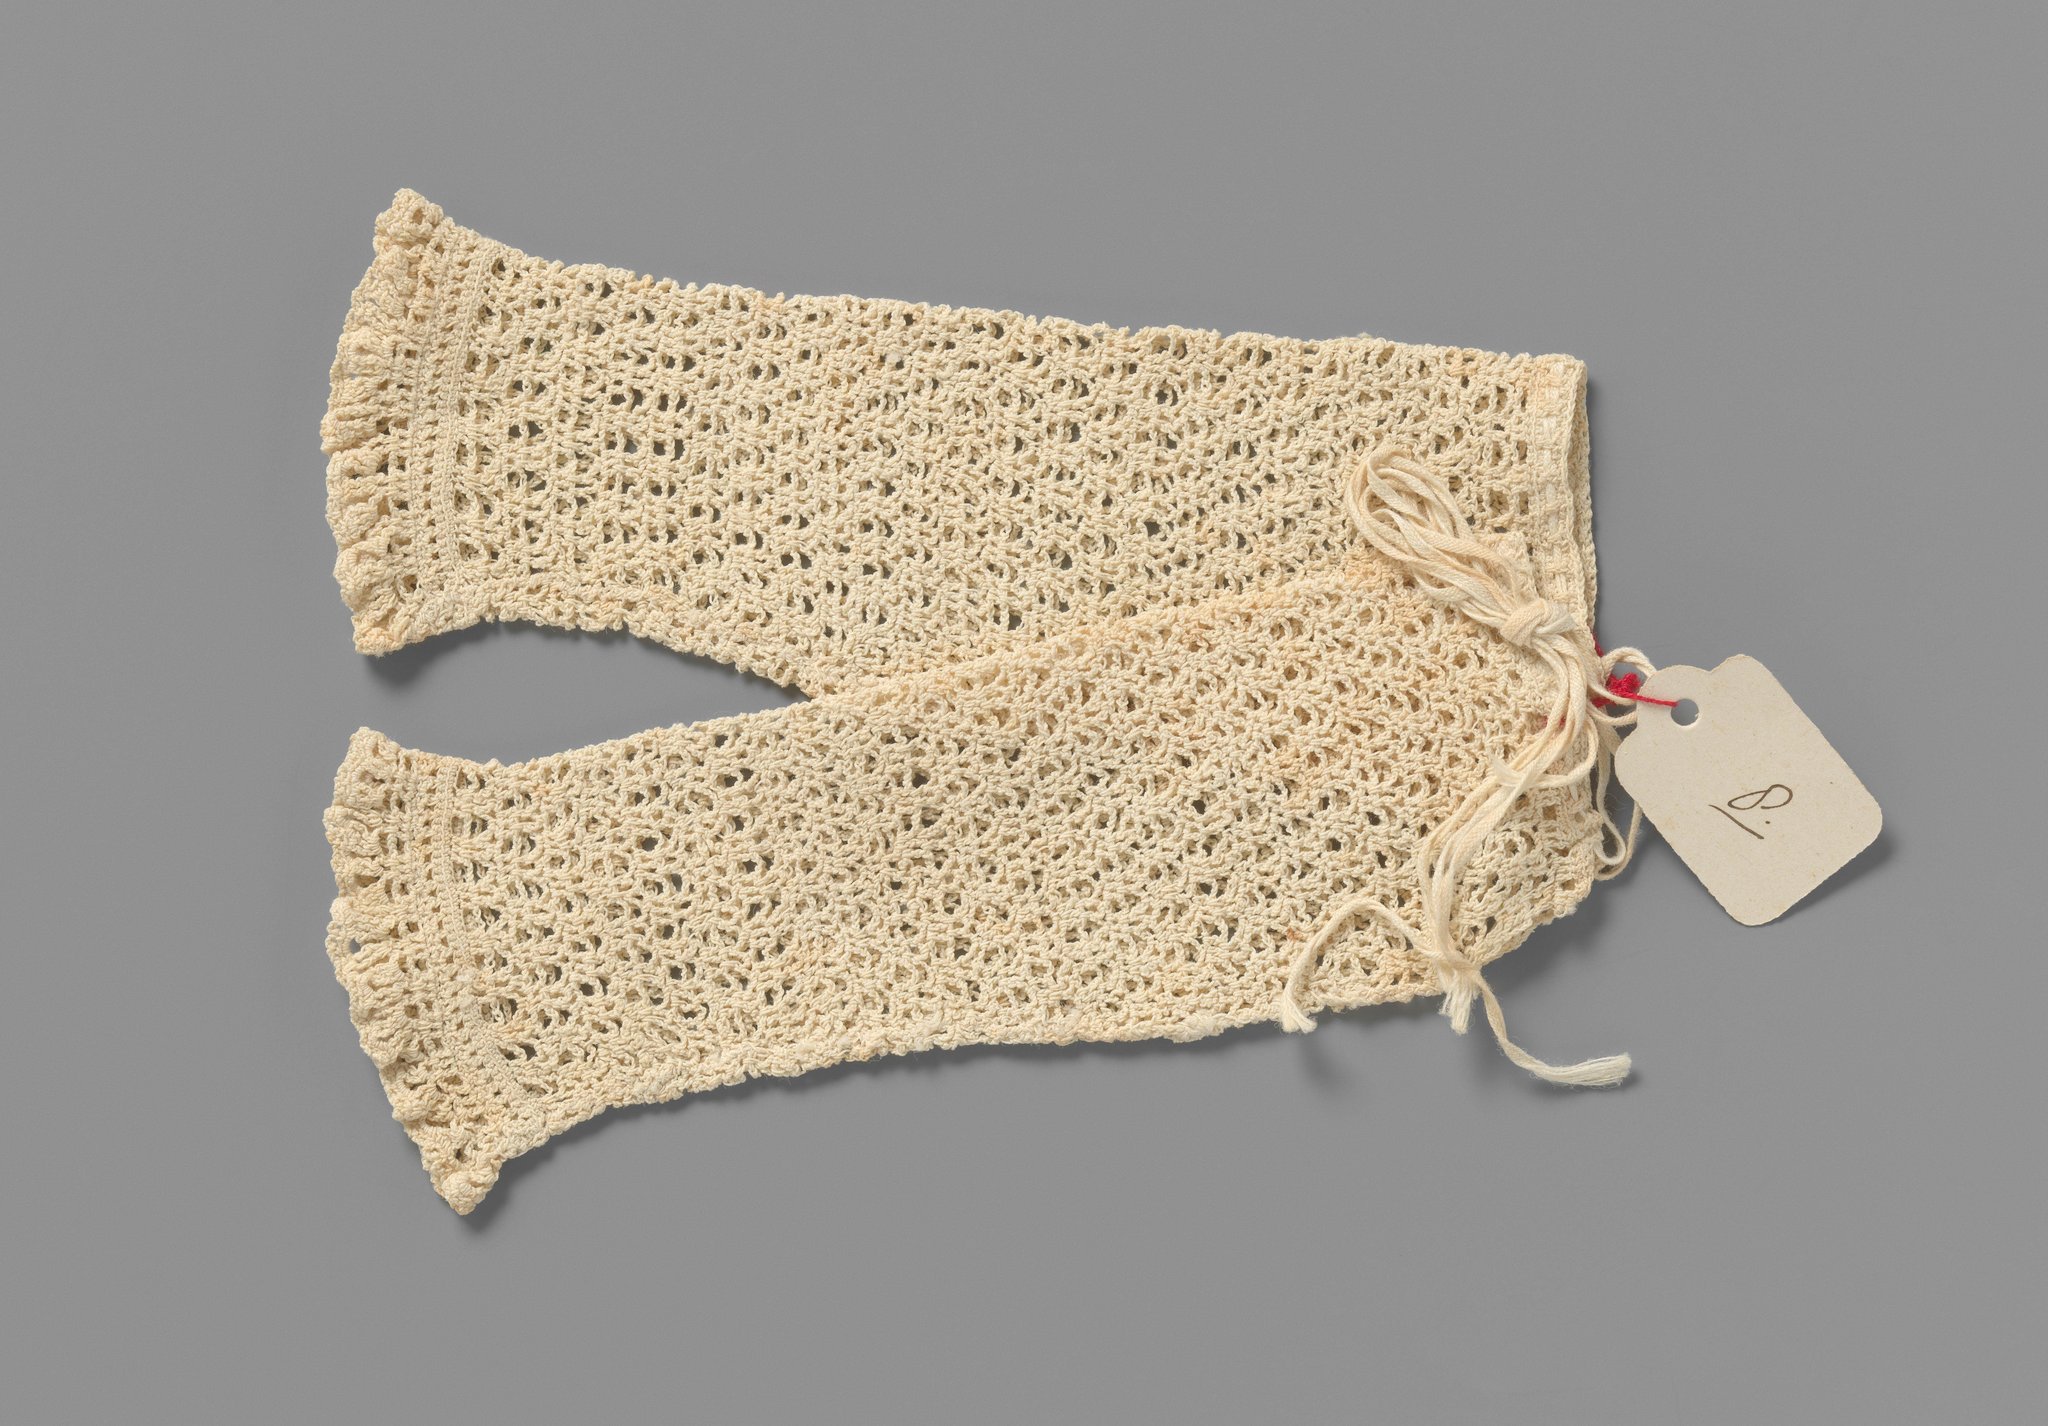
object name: childrenswear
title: Mitaine van wit gehaakt katoen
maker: Anonymous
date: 1800-1820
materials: cotton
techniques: crochet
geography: netherlands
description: Mitaine van wit gehaakt katoen, bij de elleboog een split en een rijg koord, voor baby.